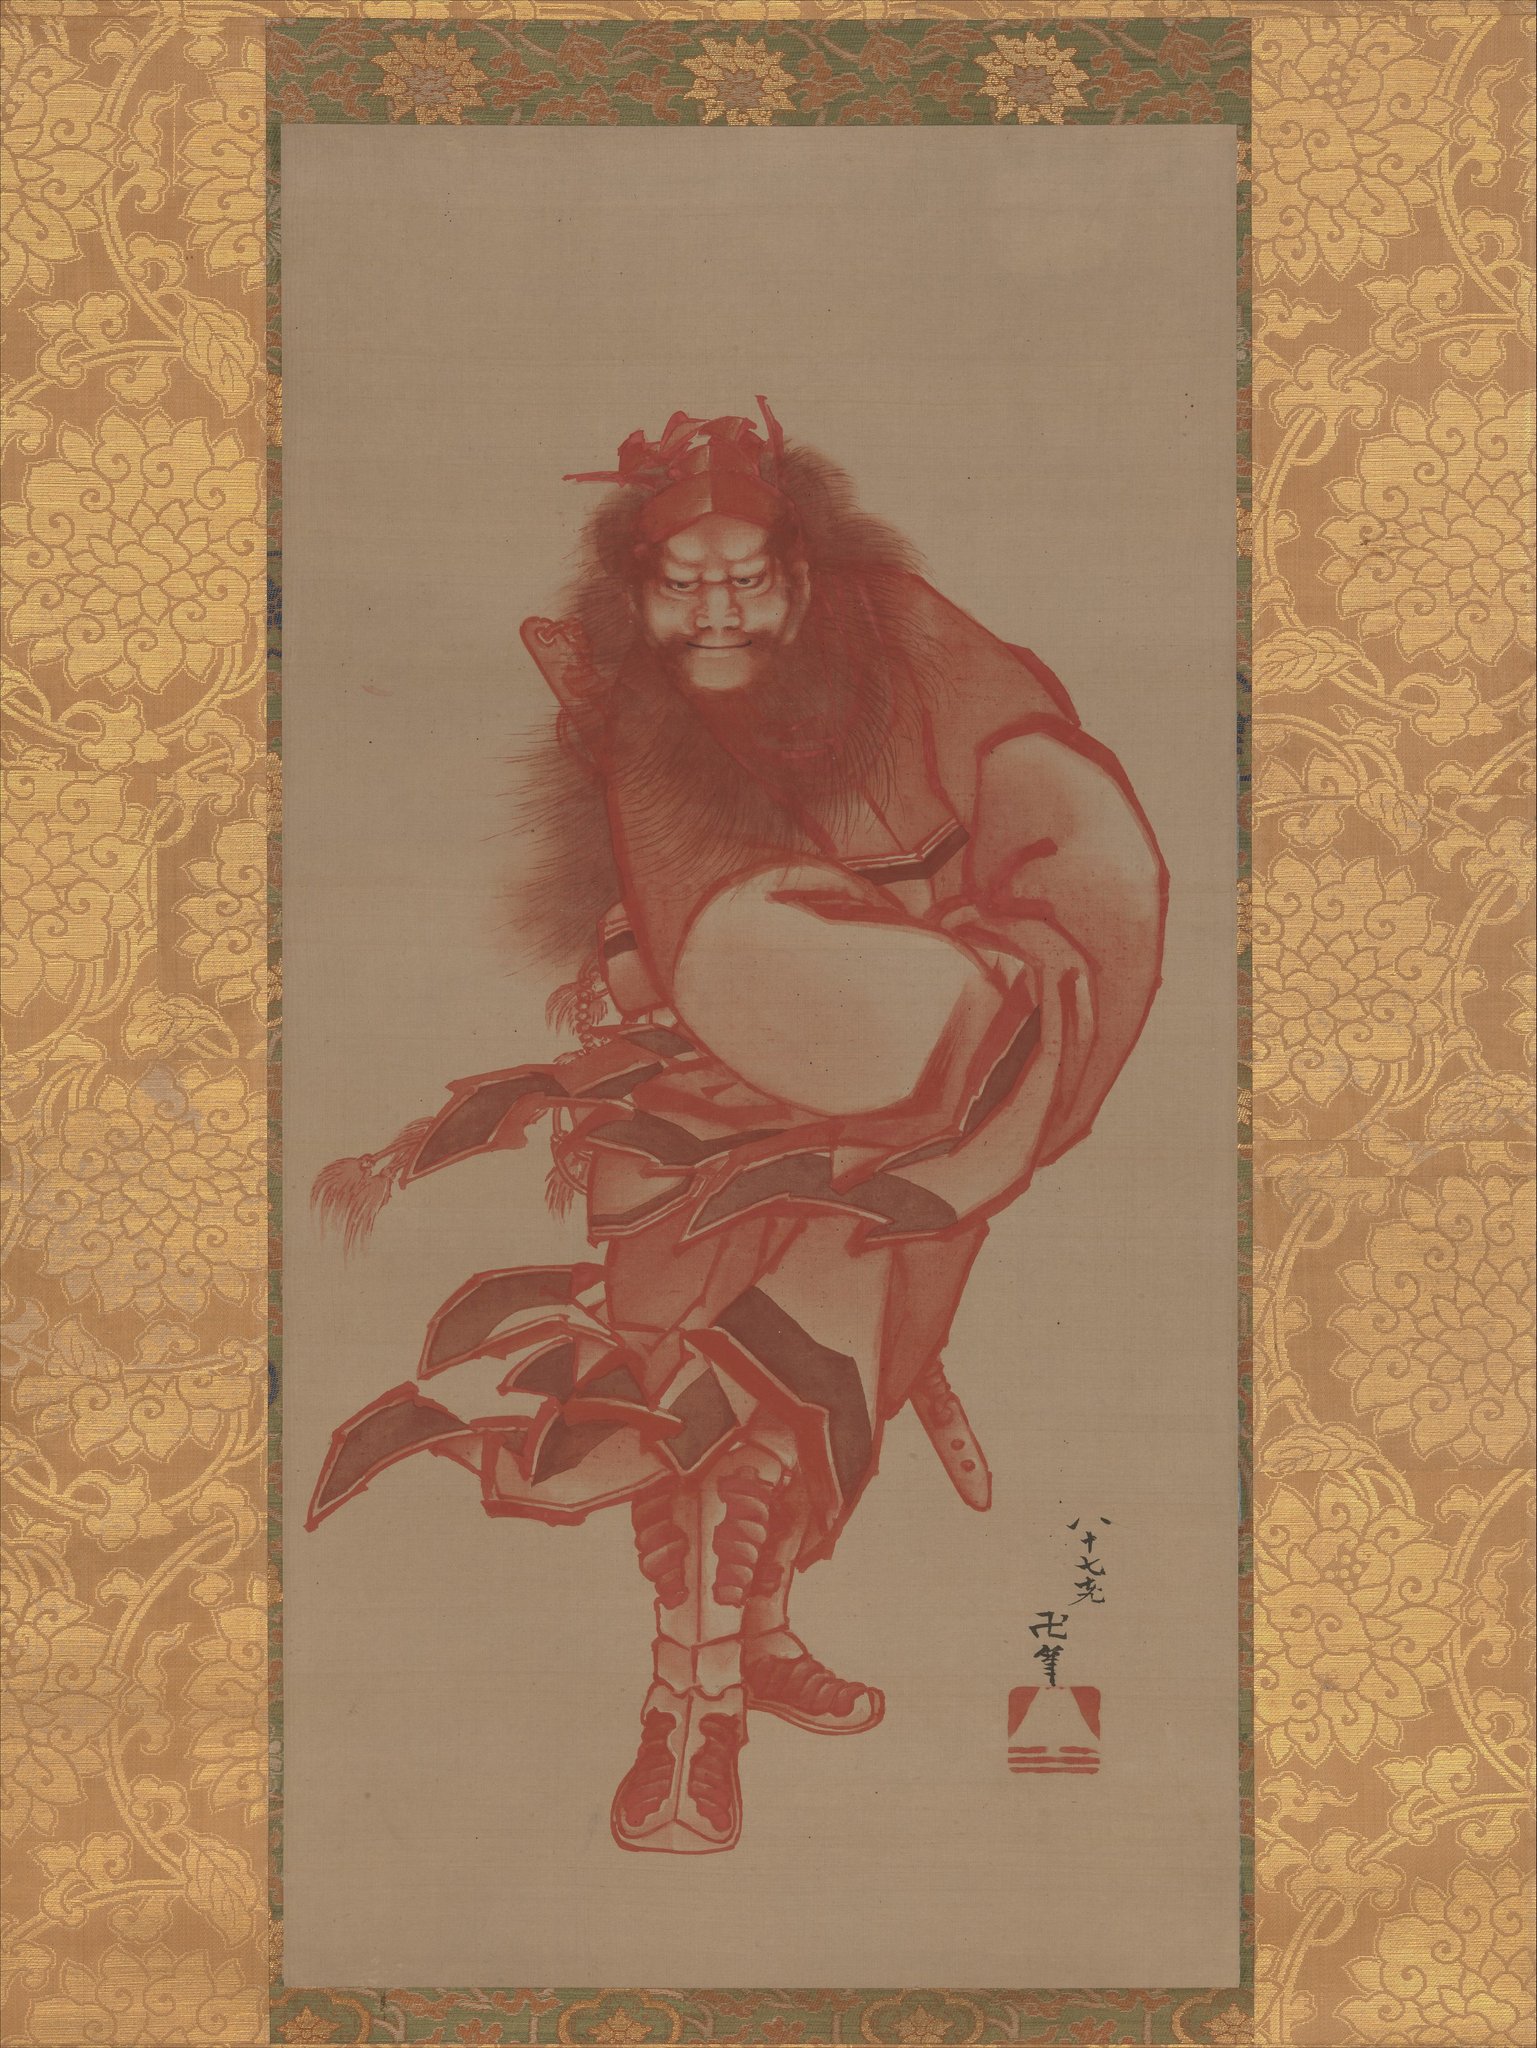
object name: hanging scroll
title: Red Zhong Kui, the Demon Queller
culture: japanese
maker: katsushika hokusai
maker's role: artist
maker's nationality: japanese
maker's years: 1760-1849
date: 1846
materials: ink, silk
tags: men